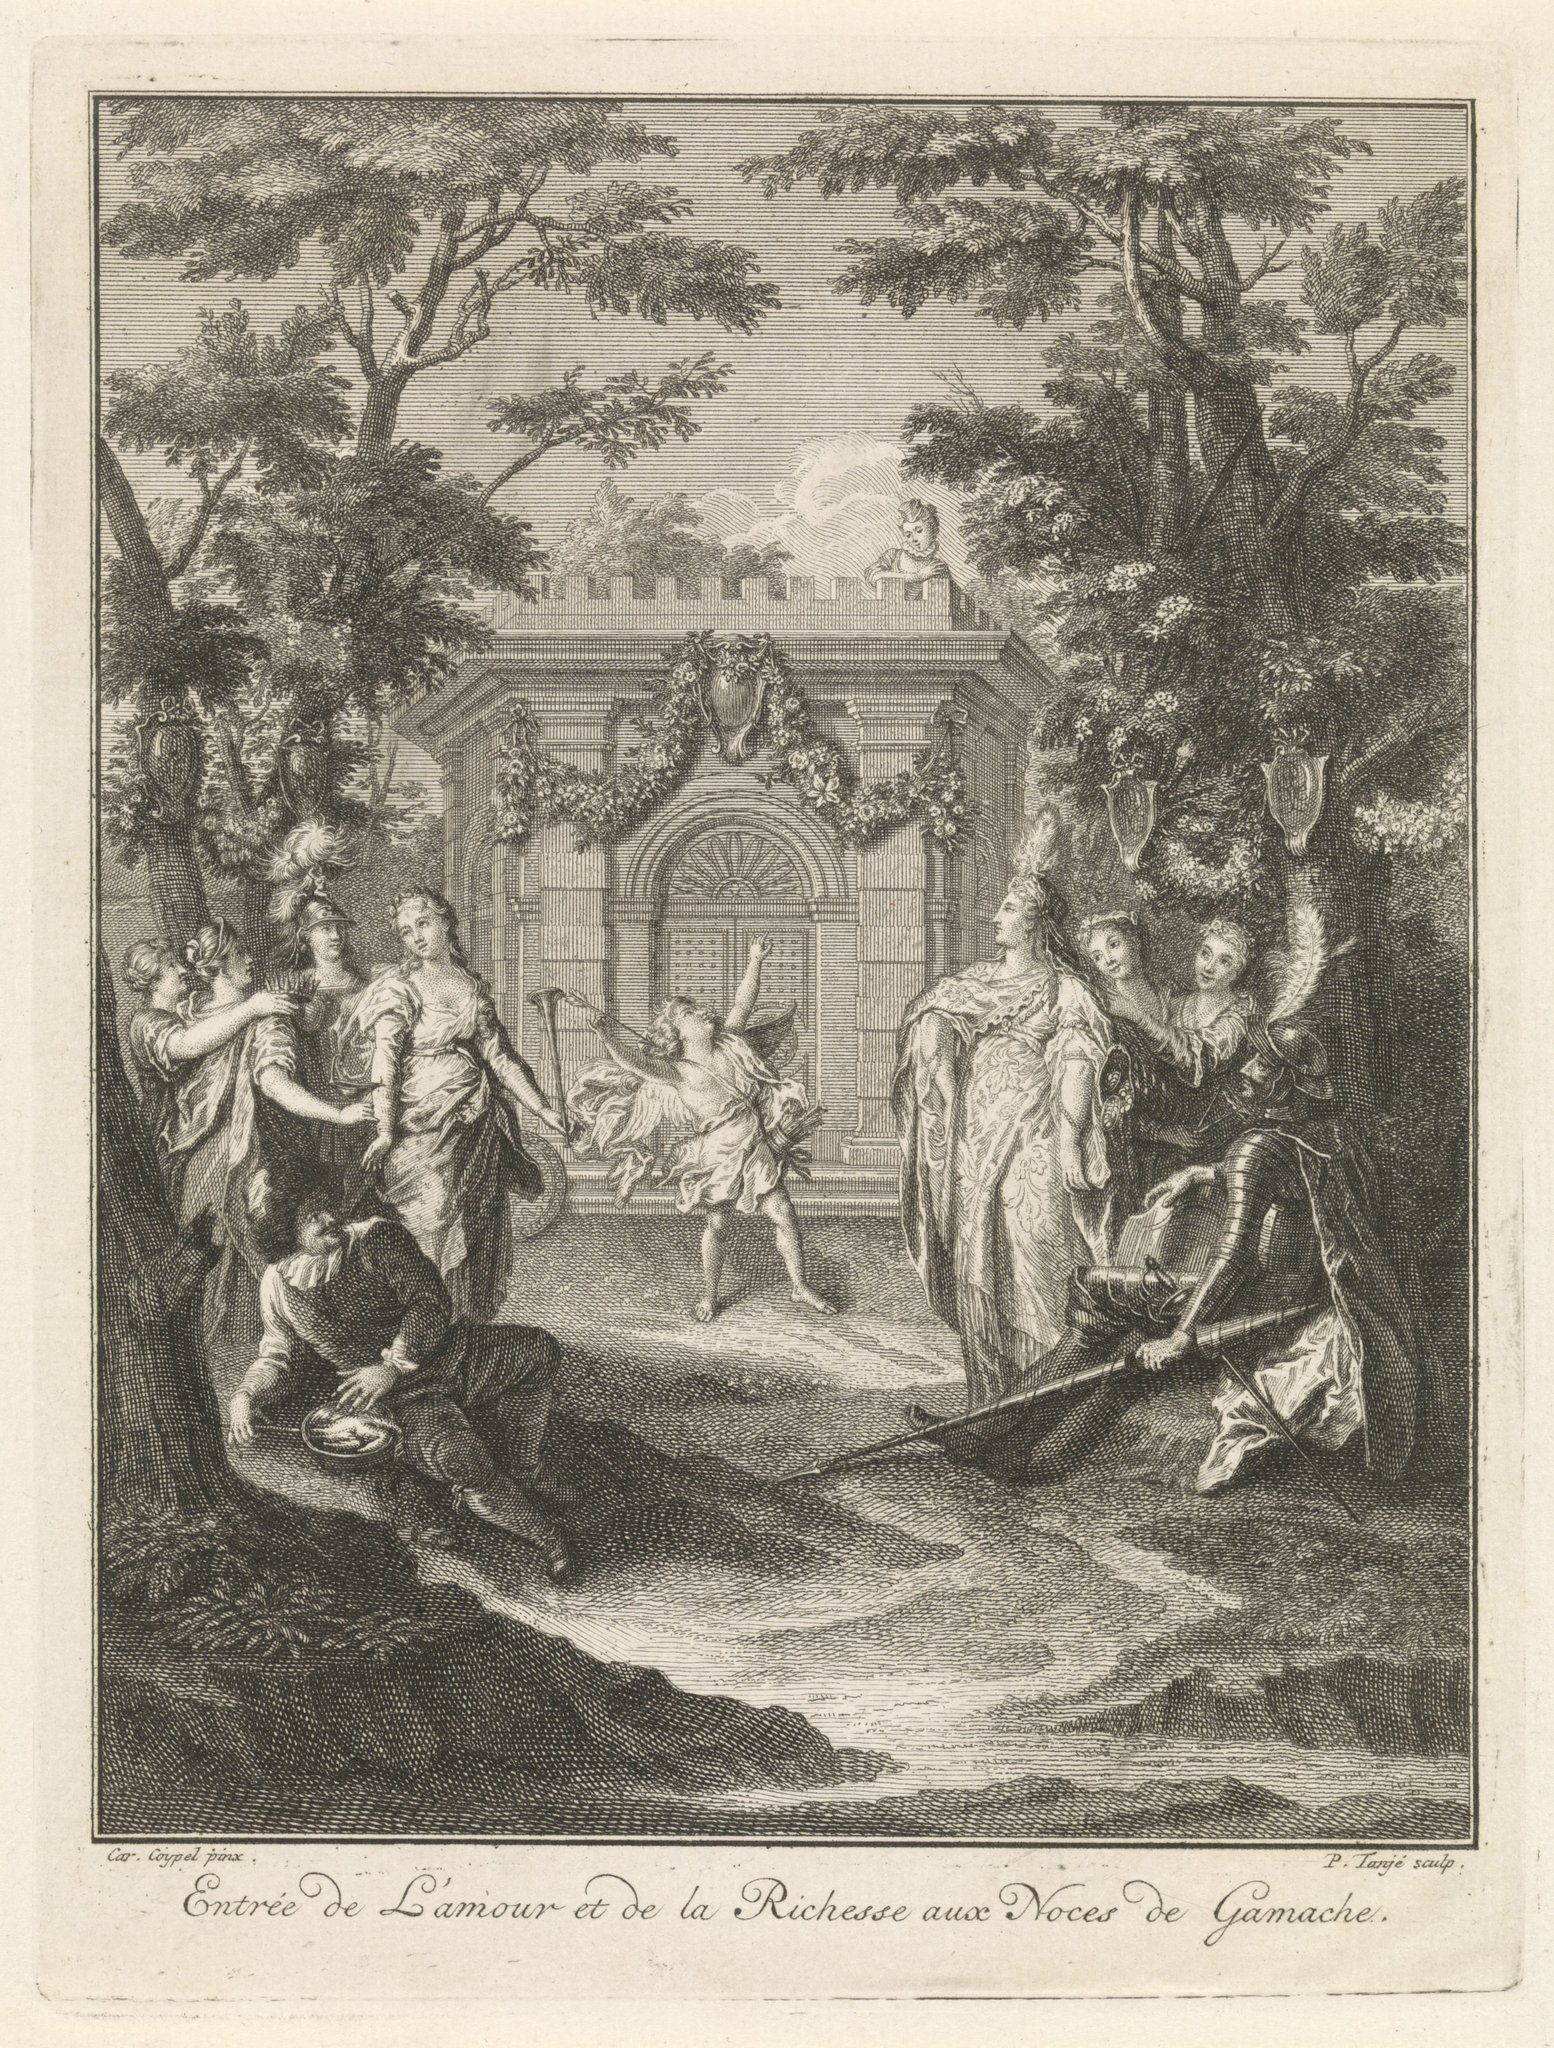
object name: book illustration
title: Entrée van Liefde en Rijkdom op het huwelijk van Gamache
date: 1716-1761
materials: paper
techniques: engraving, etching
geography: amsterdam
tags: (story of) cupid, amor (eros), don quixote, sancho panza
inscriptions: collector's mark: Lugt 2228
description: Prent gebruikt als illustratie in: Cervantes y Saavedra, Miguel de. Les principales avantures de l'admirable Don Quichotte, repréntées en figures (...) avec les explications des XXXI planches (...) tirées de l'original espagnol de Miguel de Cervantes. [Vertaald uit het Spaans door] Jacob Campo Weyerman. Den Haag: Pieter de Hondt, 1746.